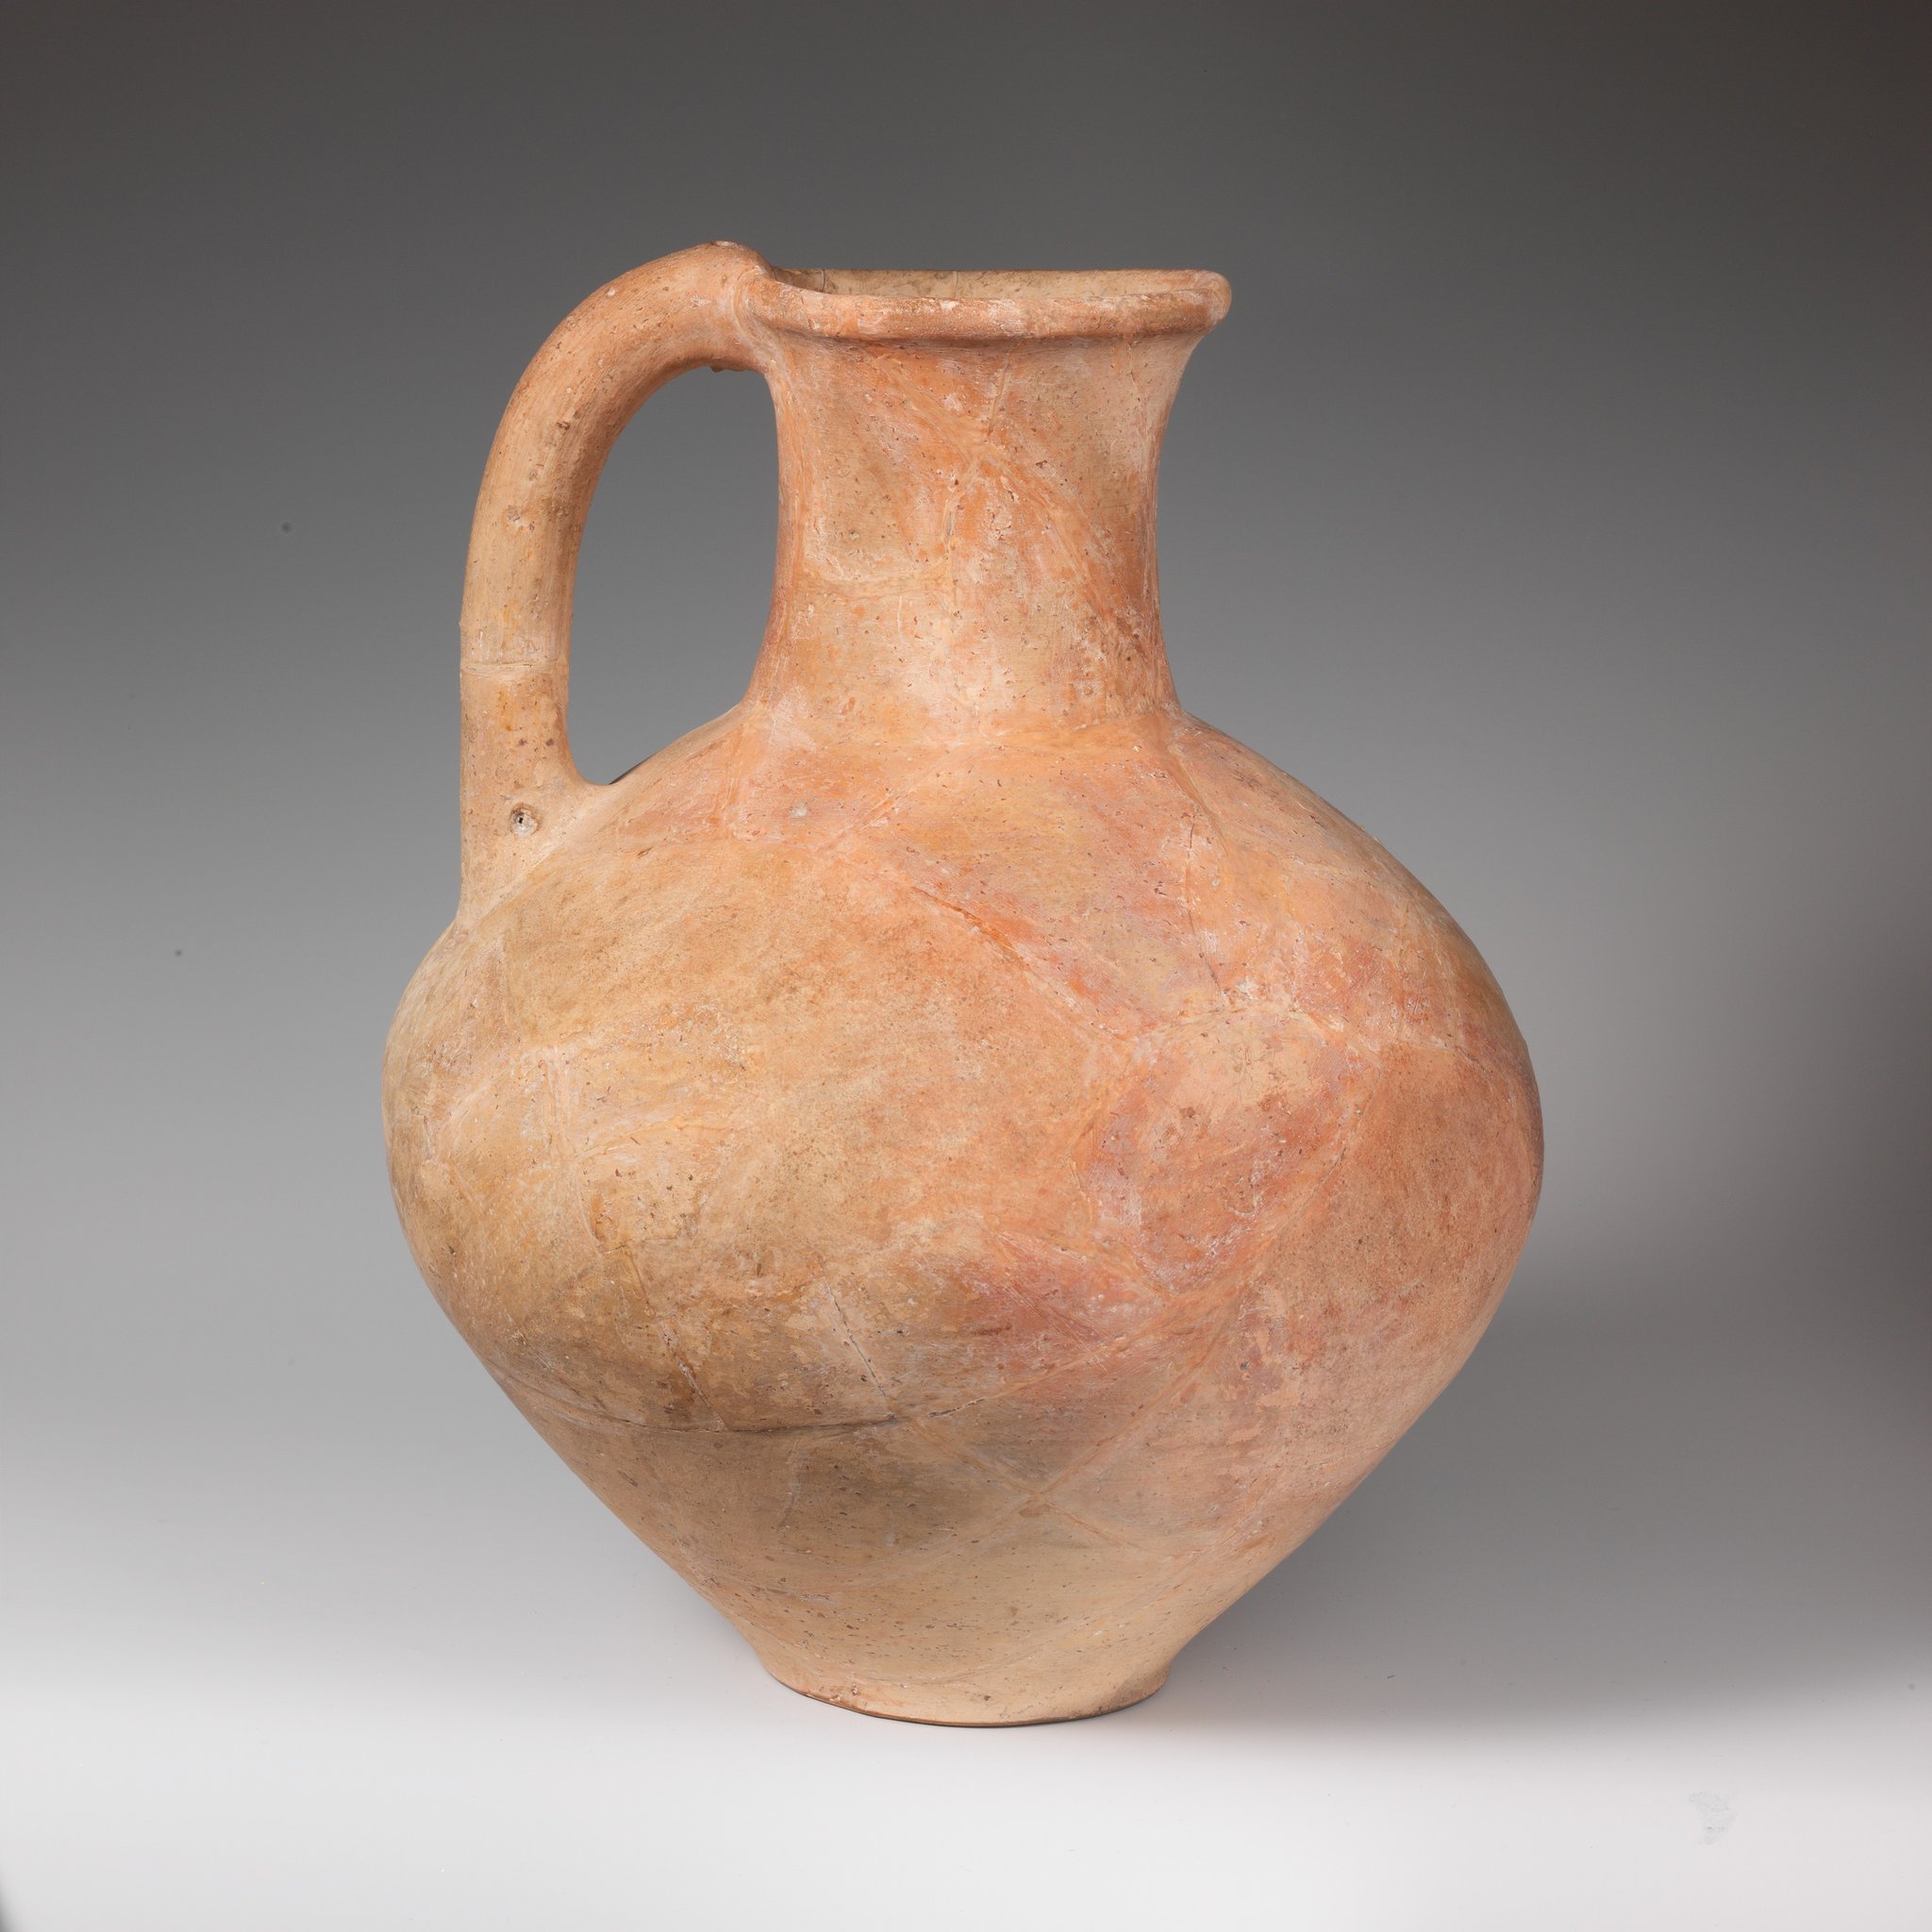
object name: jug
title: Terracotta jug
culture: mycenaean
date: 1400-1190 BCE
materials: terracotta